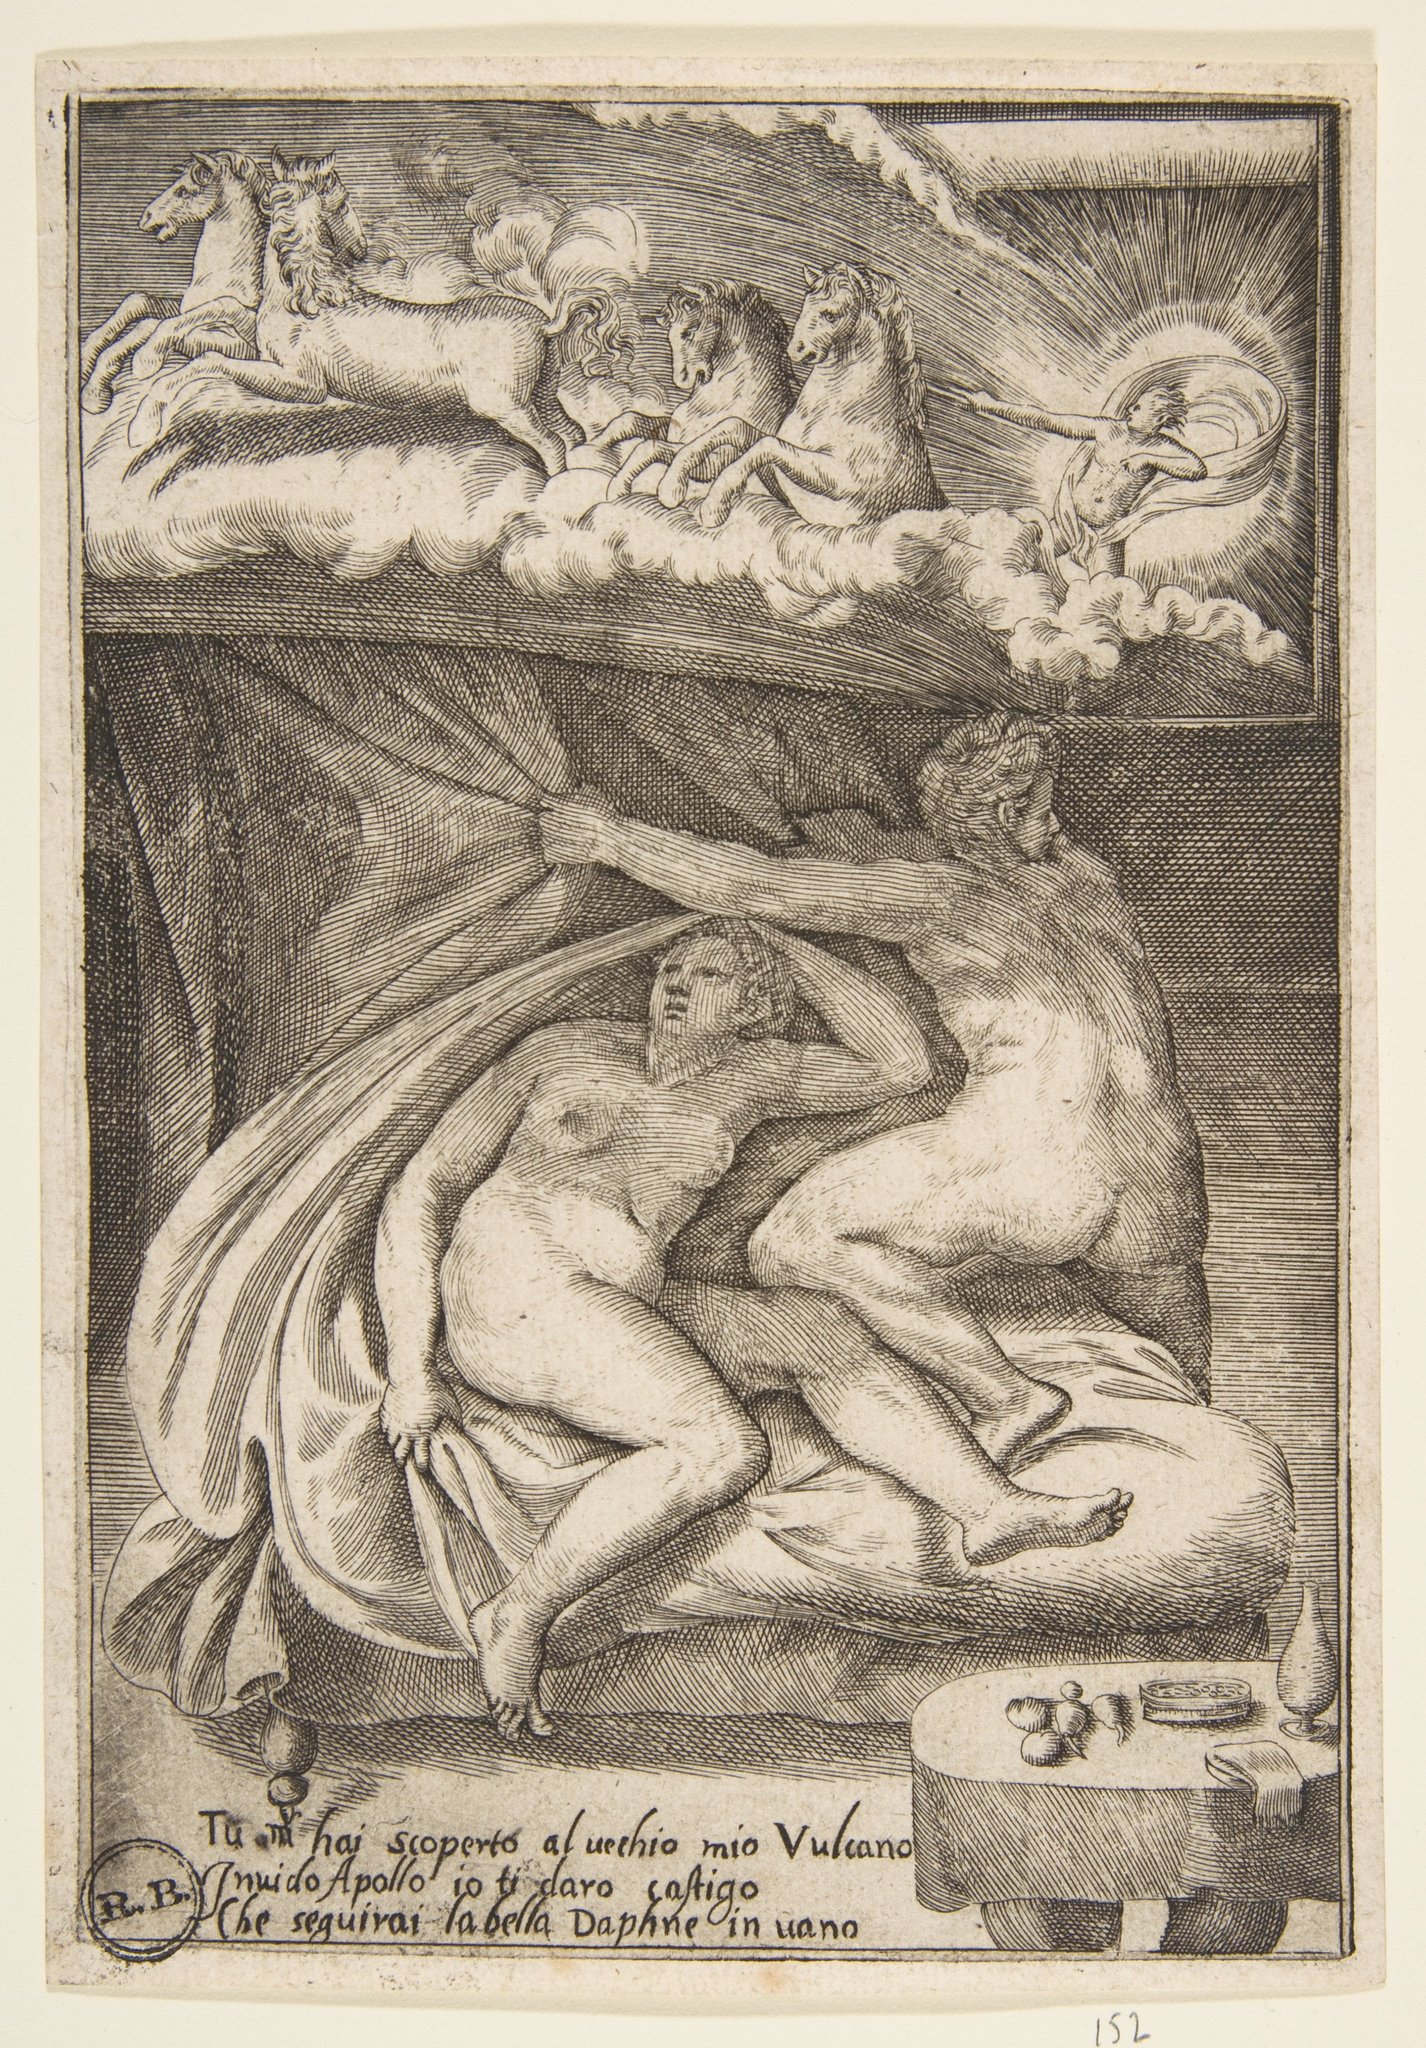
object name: print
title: Venus and Mars discovered by Apollo, from "The Loves of the Gods"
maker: giulio bonasone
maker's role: artist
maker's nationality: italian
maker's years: 1510-1576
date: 1531-1560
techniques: engraving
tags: apollo,mars,venus,horses